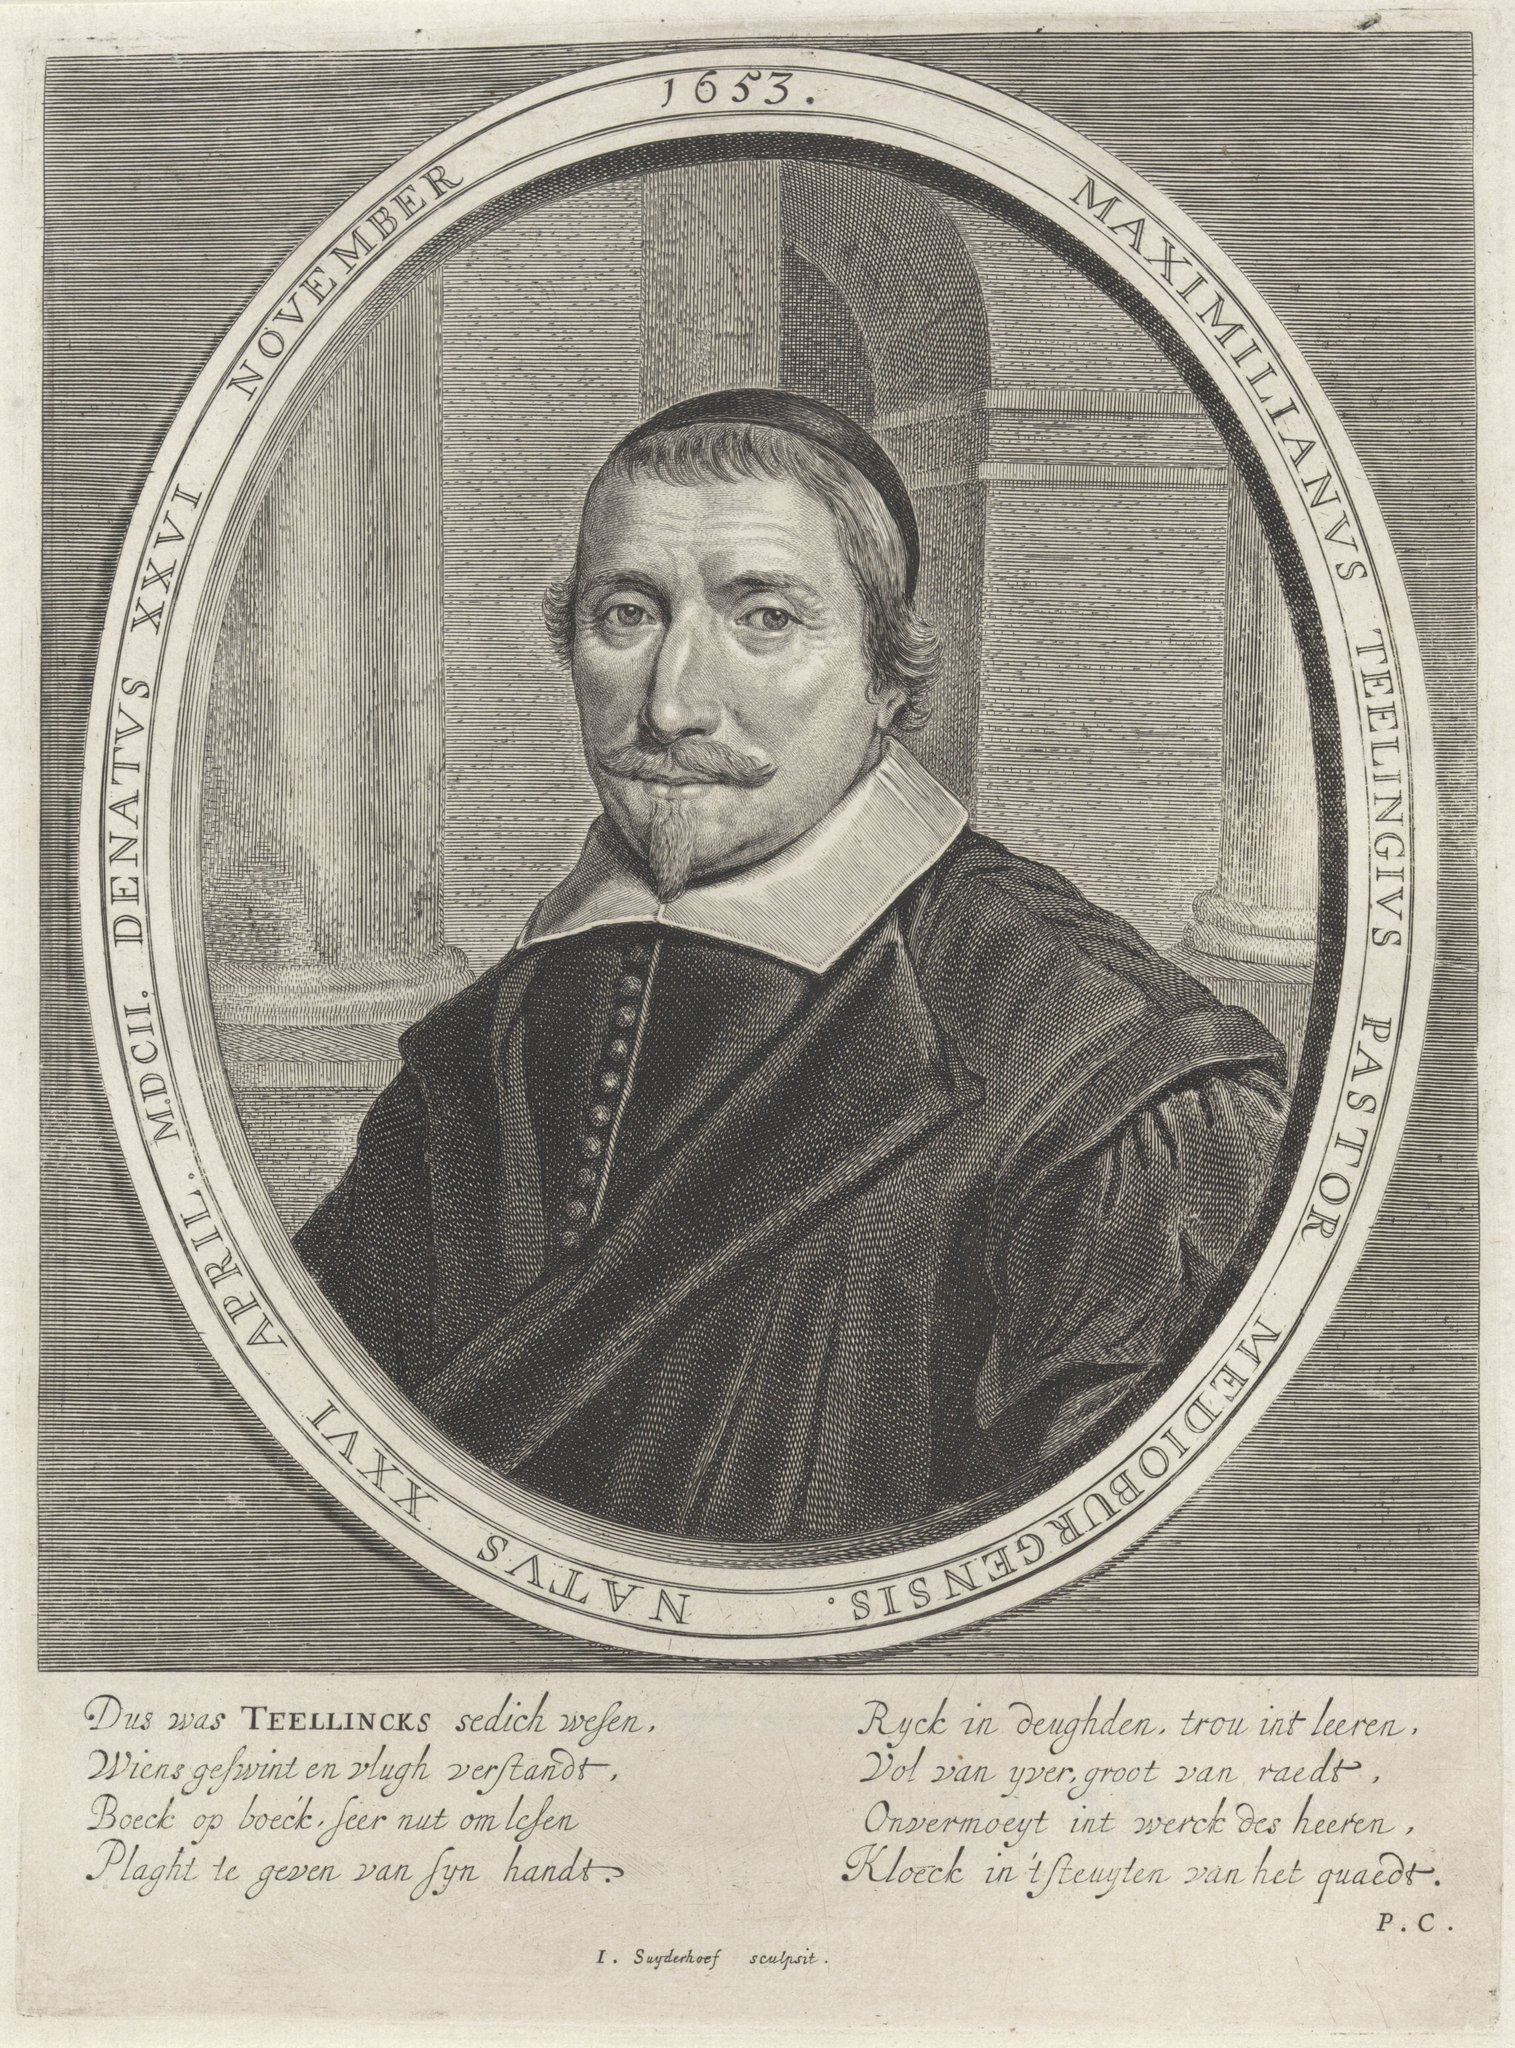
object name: print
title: Portret van Maximiliaen Teellinck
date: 1653-1686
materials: paper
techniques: engraving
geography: haarlem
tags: middelburg, functionaries and dignitaries ~ protestant churches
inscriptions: collector's mark: Lugt 240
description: Portret van Maximiliaen Teellinck, predikant te Middelburg. Onderaan in de marge een twee vierregelige verzen in het Nederlands.